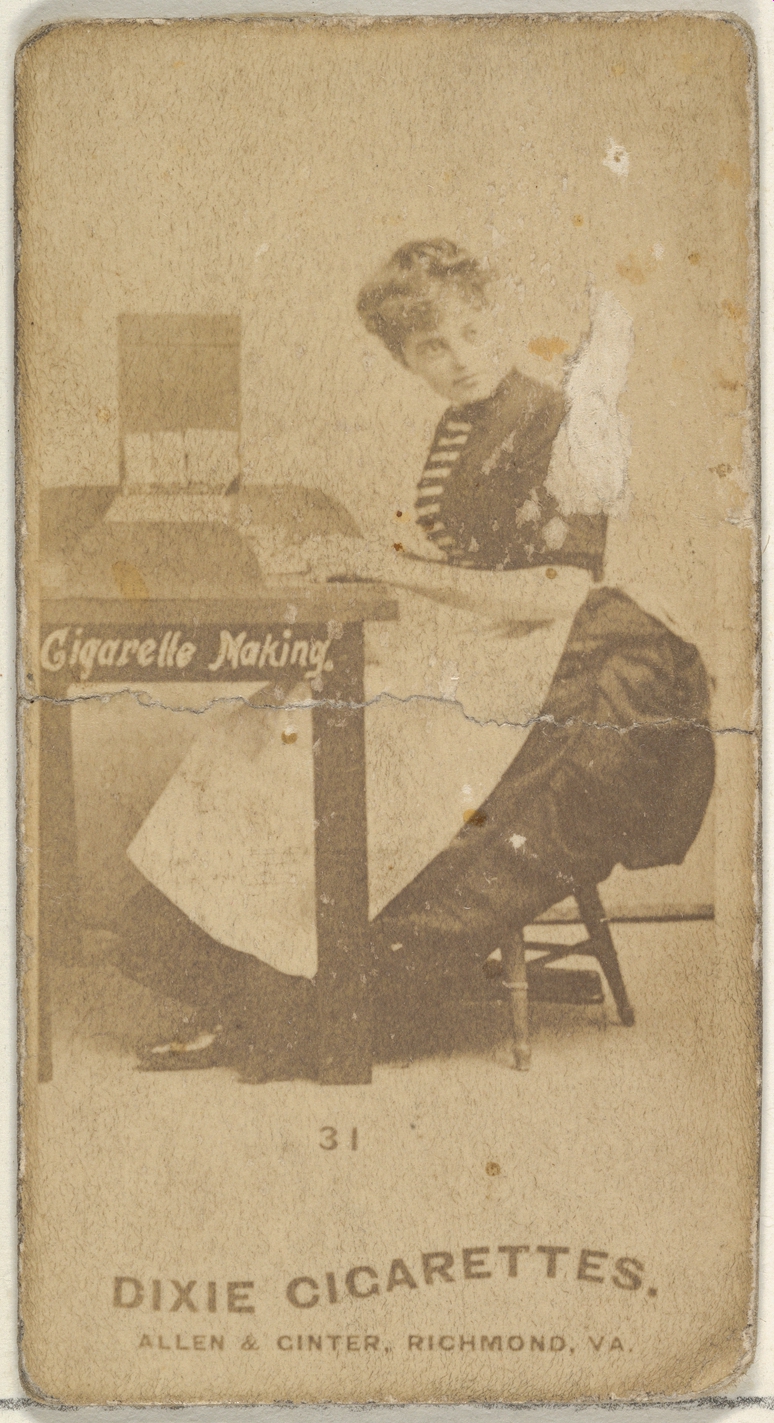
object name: photograph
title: Card 31, from the series, Cigarette Making Girls (N46) for Virginia Brights Cigarettes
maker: allen & ginter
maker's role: publisher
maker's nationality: american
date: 1888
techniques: albumen silver print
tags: portraits,women